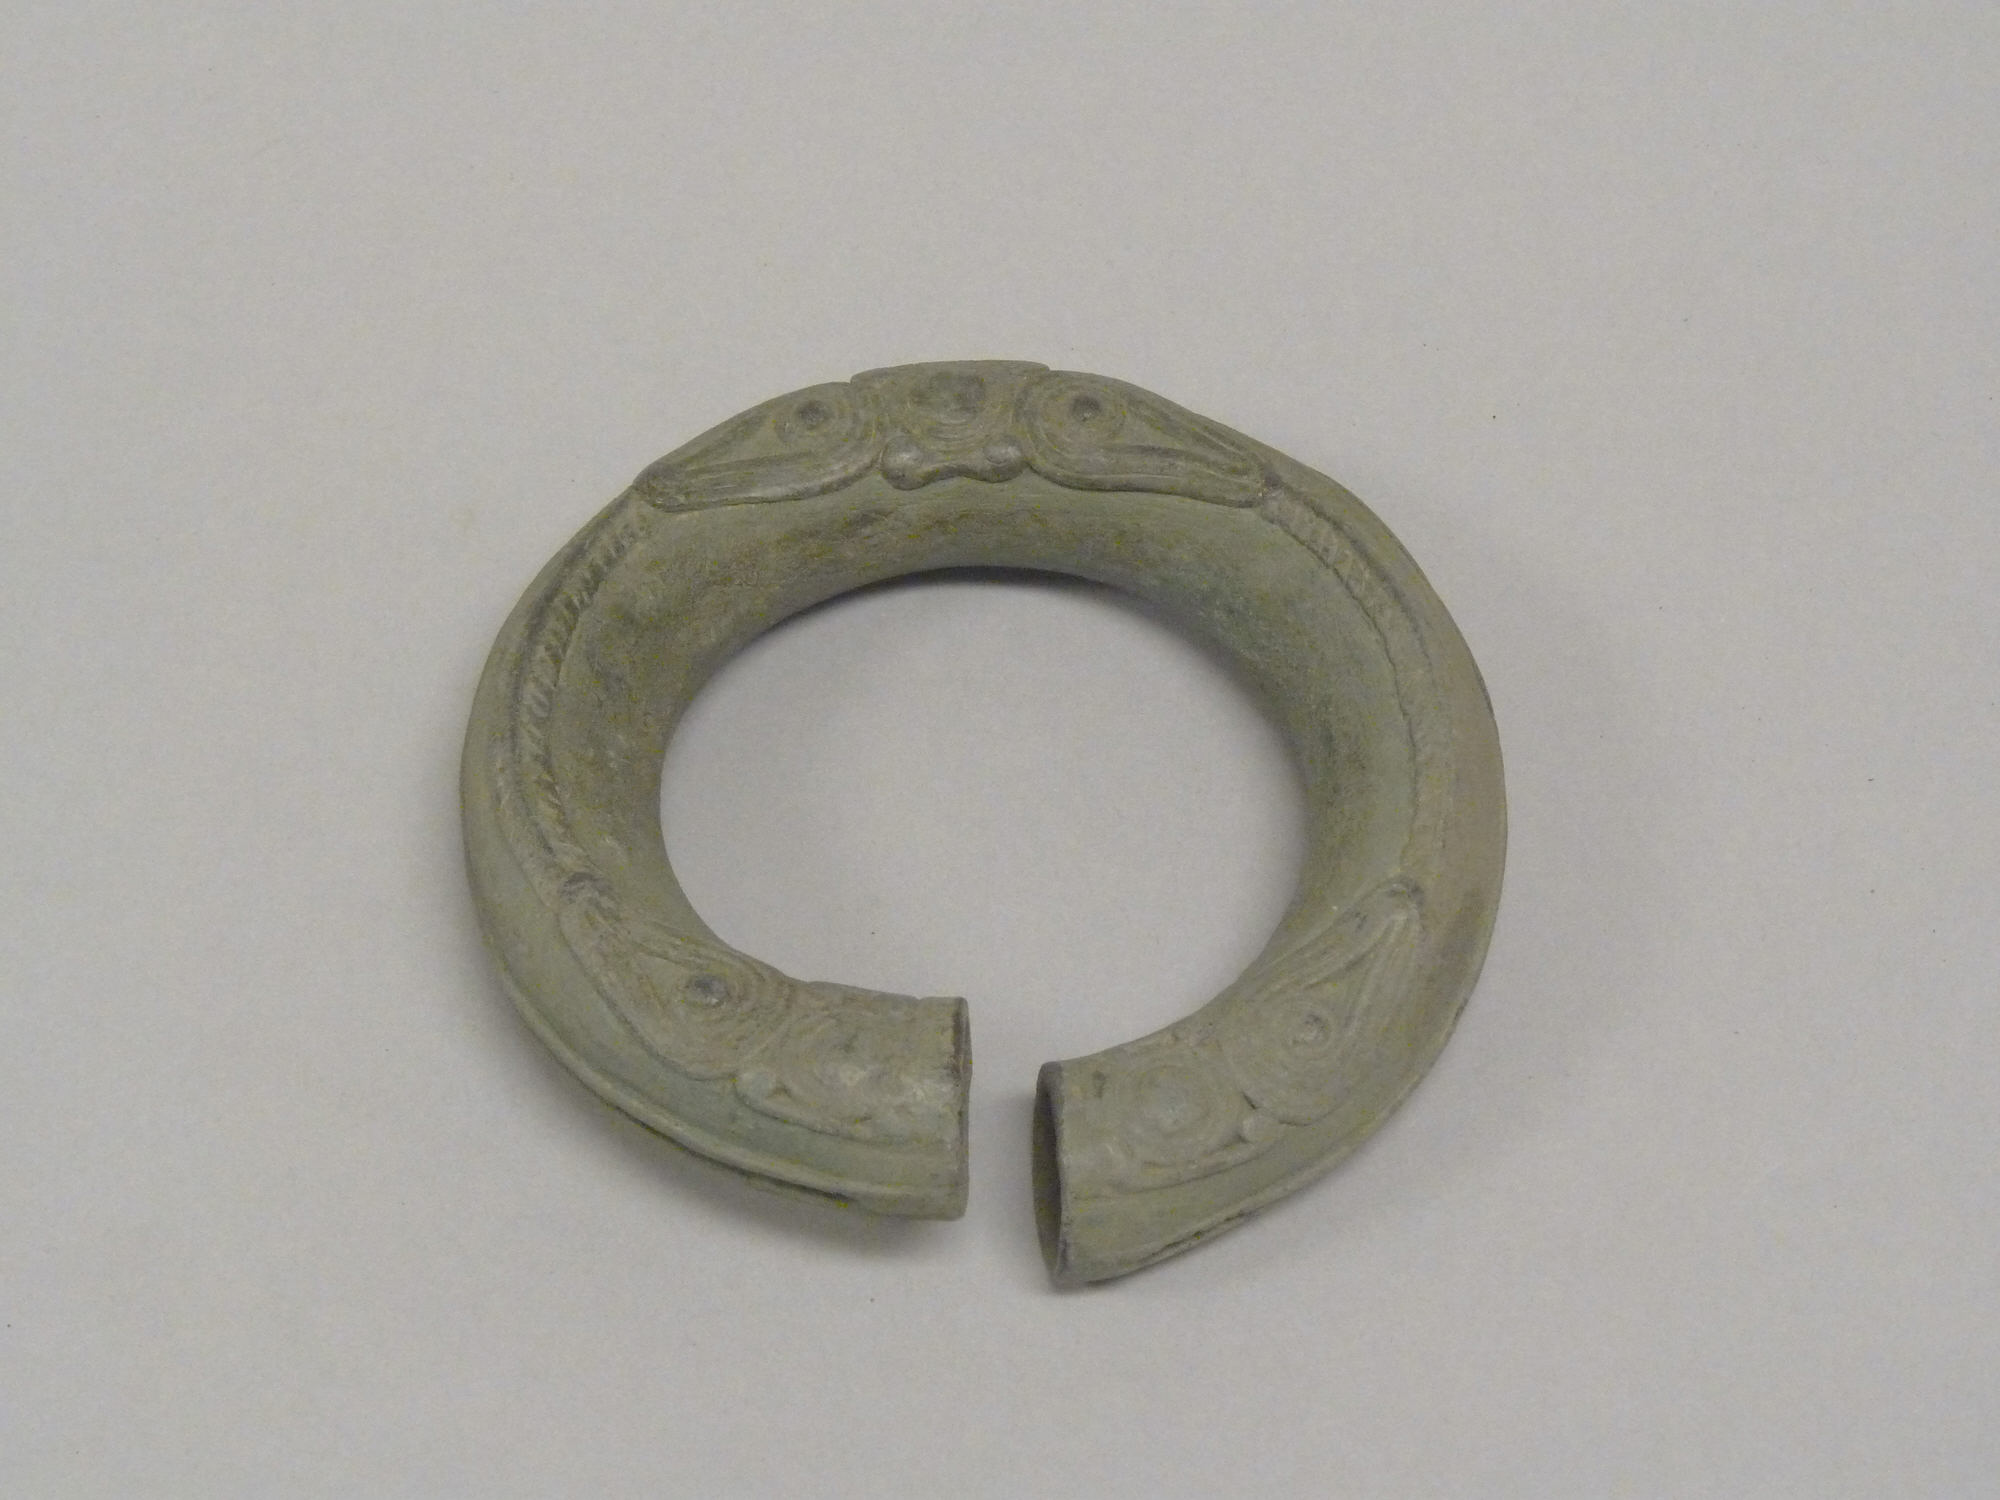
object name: bangle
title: Hollow Bangle with Applied Decoration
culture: thai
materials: bronze